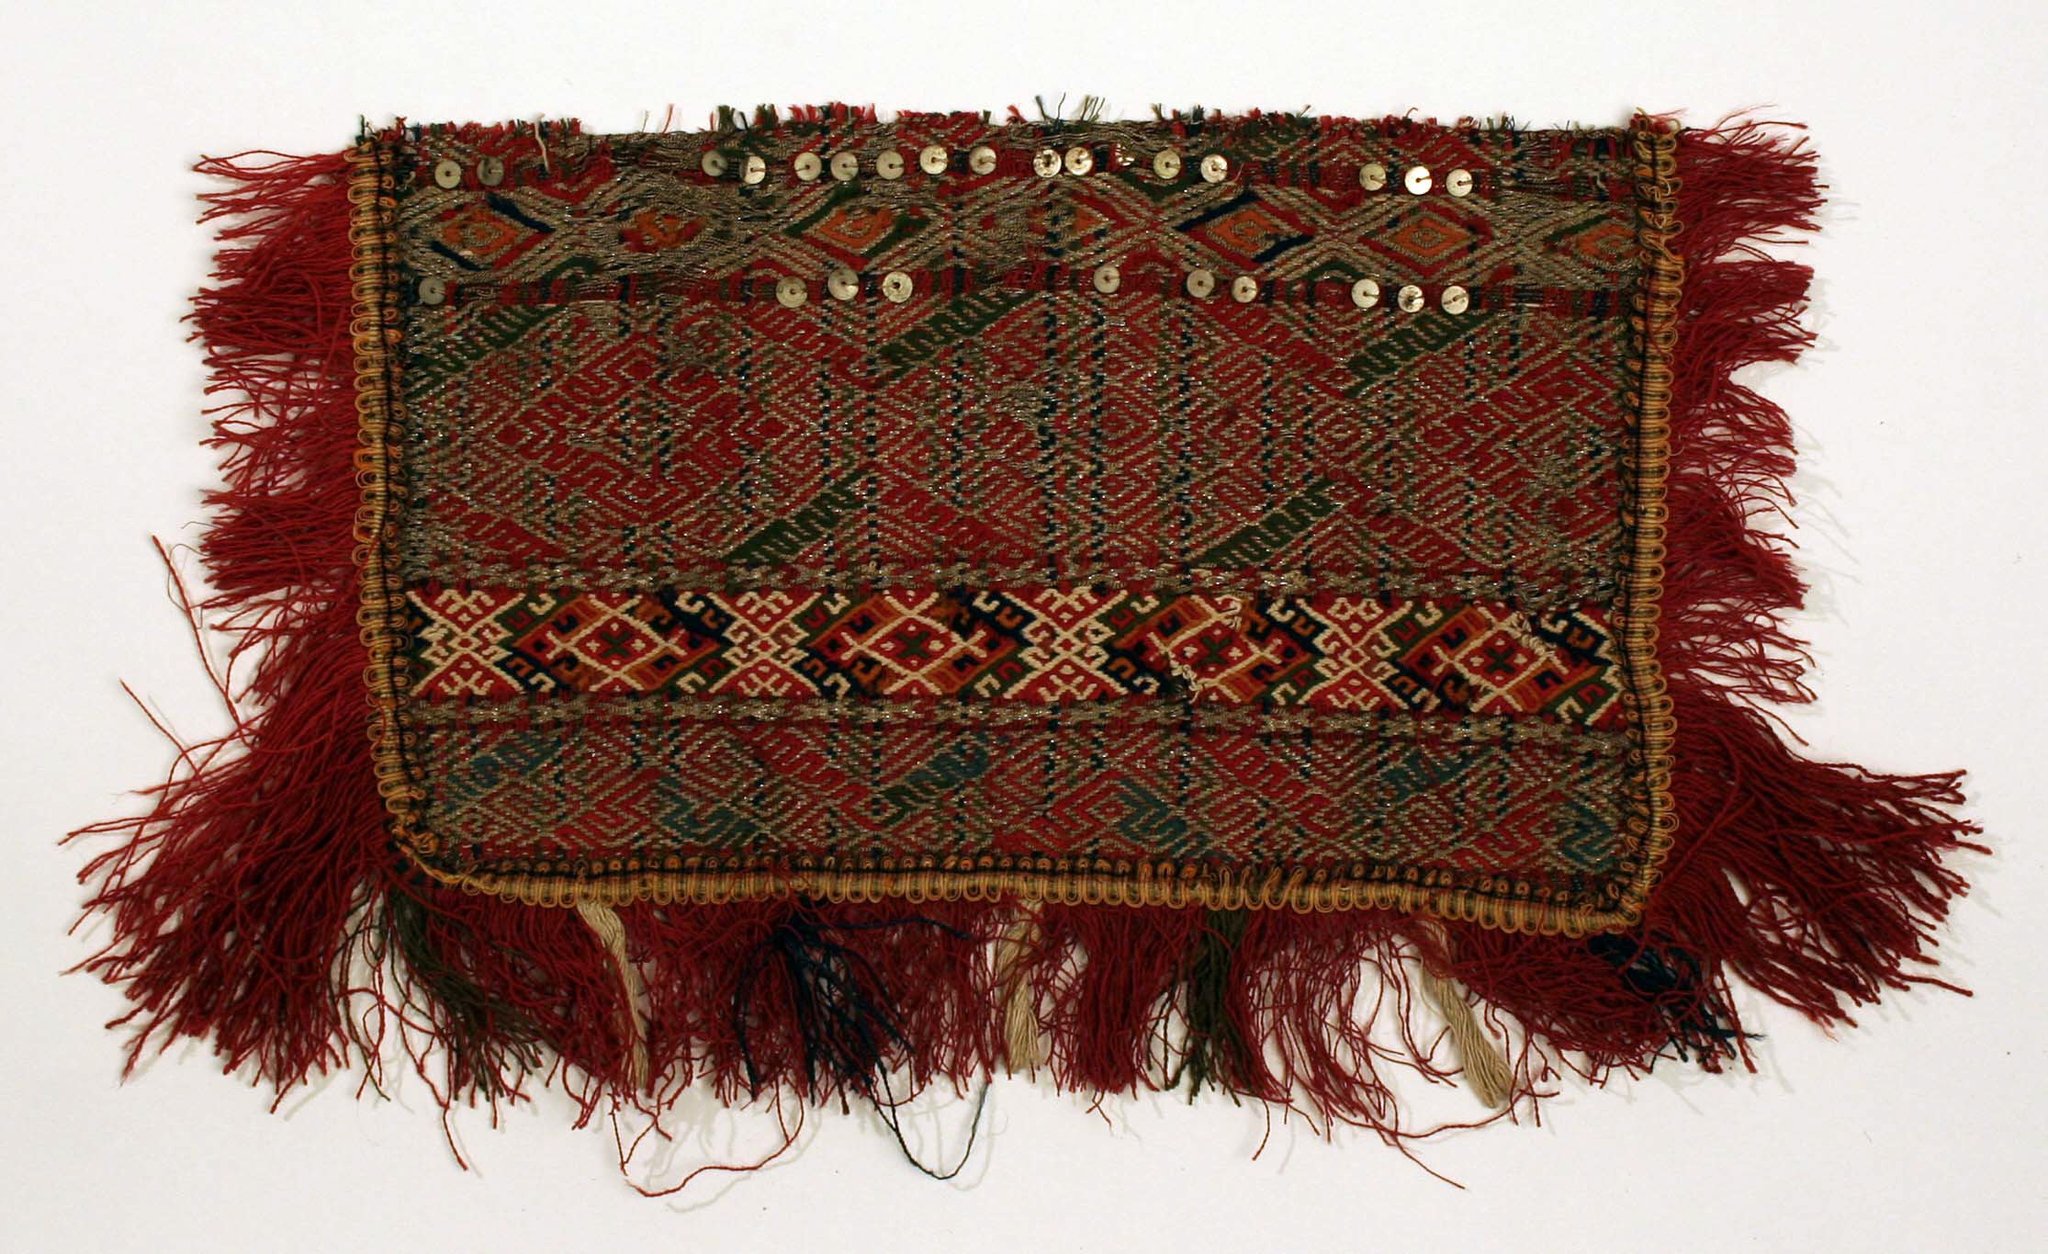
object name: apron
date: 1801-1900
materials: wool